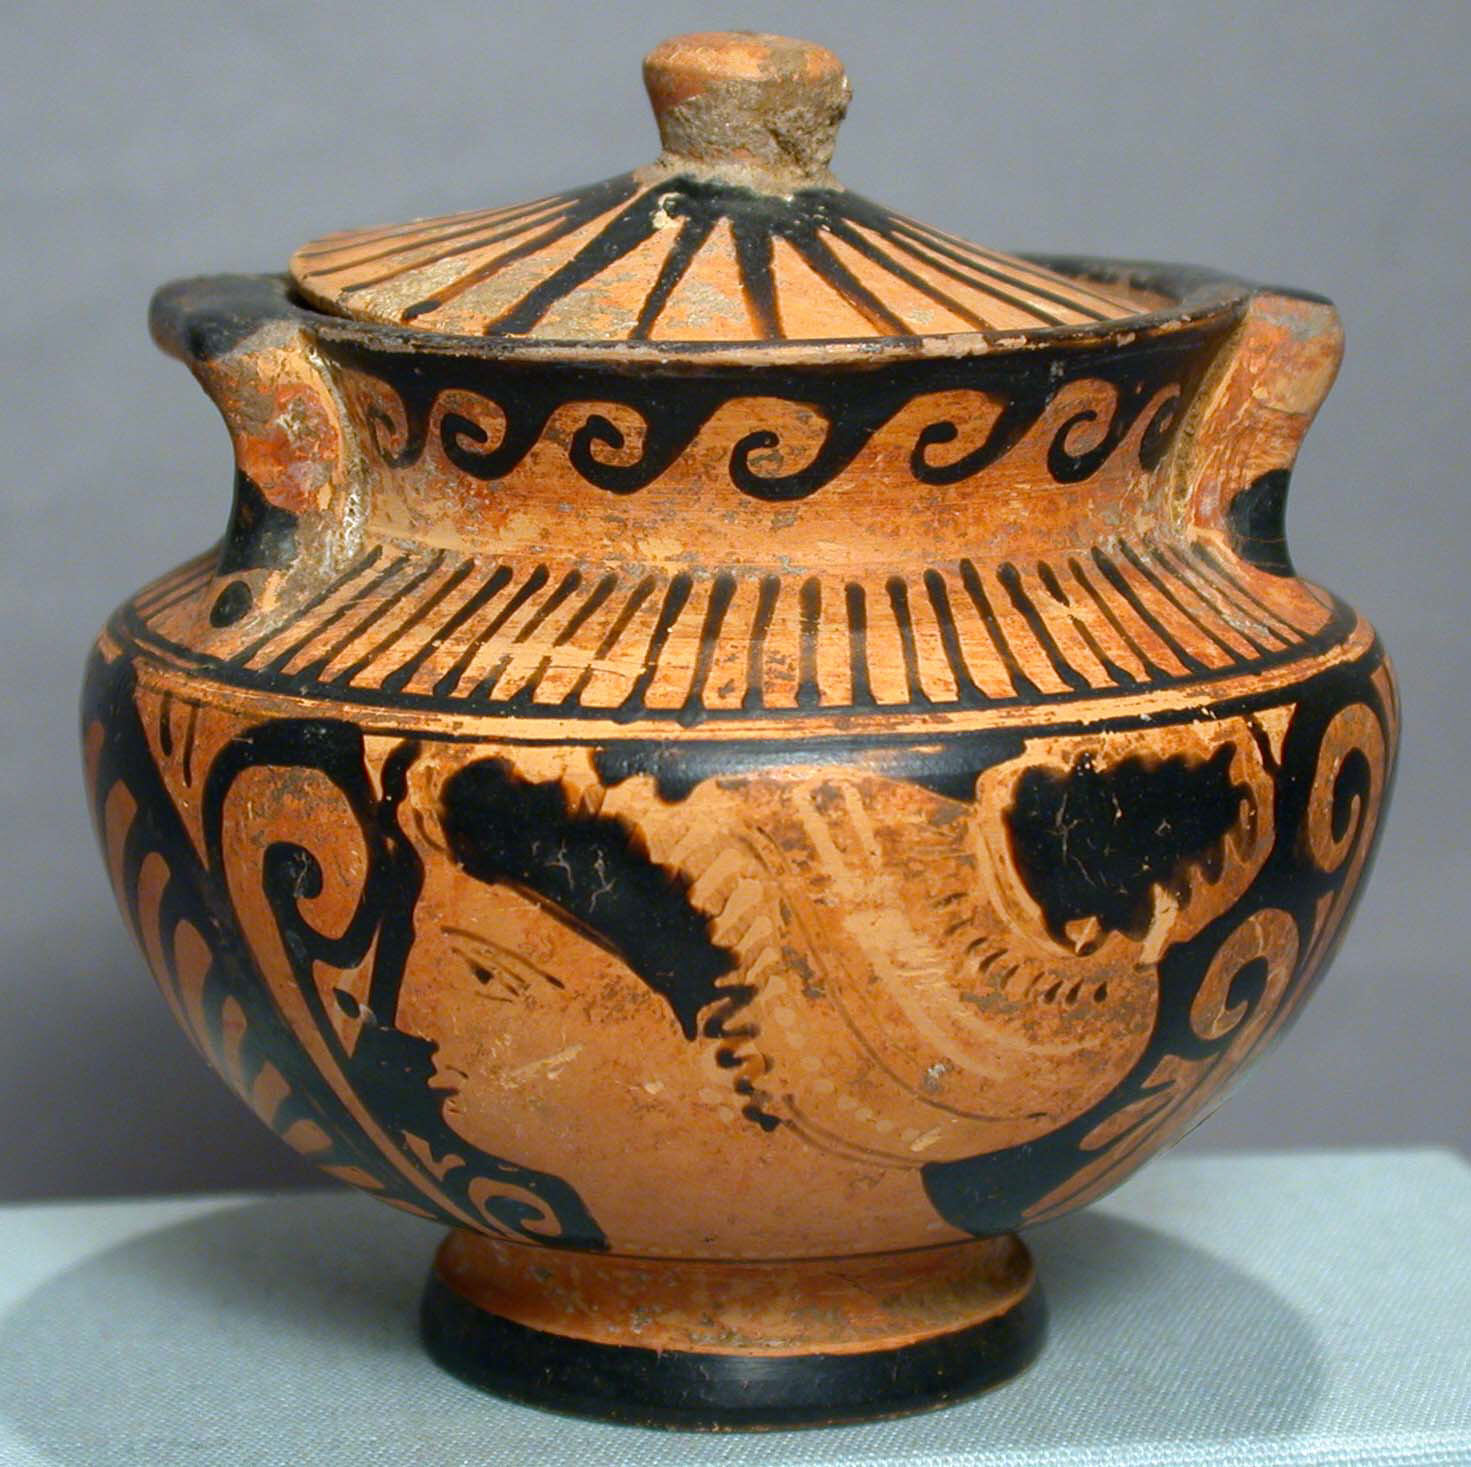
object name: stamnos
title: Terracotta stamnos (jar) with lid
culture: greek or south italian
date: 350-301 BCE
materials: terracotta